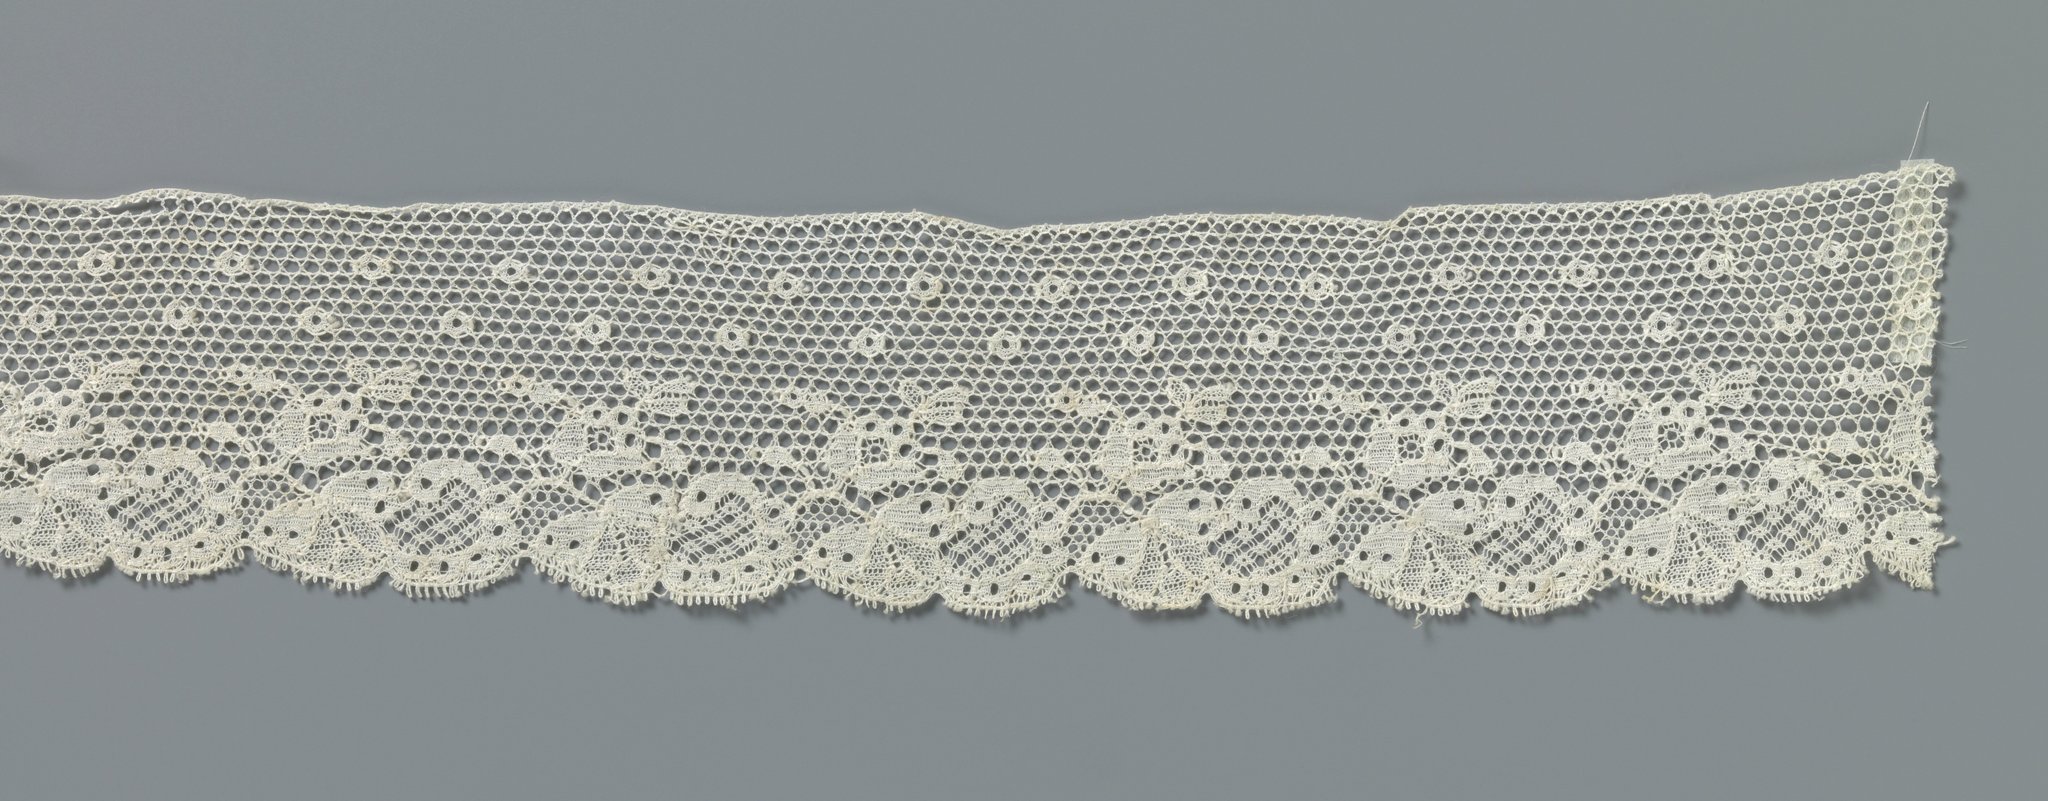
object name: strip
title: Strook machinale kant met c-vormig blad en waaiervormige bloem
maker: Anonymous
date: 1875-1899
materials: cotton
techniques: lace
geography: europe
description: Strook machinale kant. Onder twee rijen moesjes bestaat het zich herhalende patroon langs de onderzijde van de strook uit een gebogen steeltje met een naar beneden buigende waaiervormige bloem, waar een c-vormige blad tegenaan ligt. Aan het gebogen steeltje ontspringt een omhoog gericht kelkbloempje. De motieven lijken te zijn gemaakt in netslag en linnenslag met enkele ronde uitsparingen en zijn voorzien van contourdraden. Ze zijn met elkaar verbonden door een machinale Parijse grond. Als siergrond is een machinale sneeuwvlokkengrond toegepast in de ruimte die door het c-vormige blad wordt omsloten. De bovenzijde van de strook is recht afgewerkt. De schulpenrand langs de onderzijde komt voort uit het patroon met de bloemen en bladeren en is afgewerkt met picots.